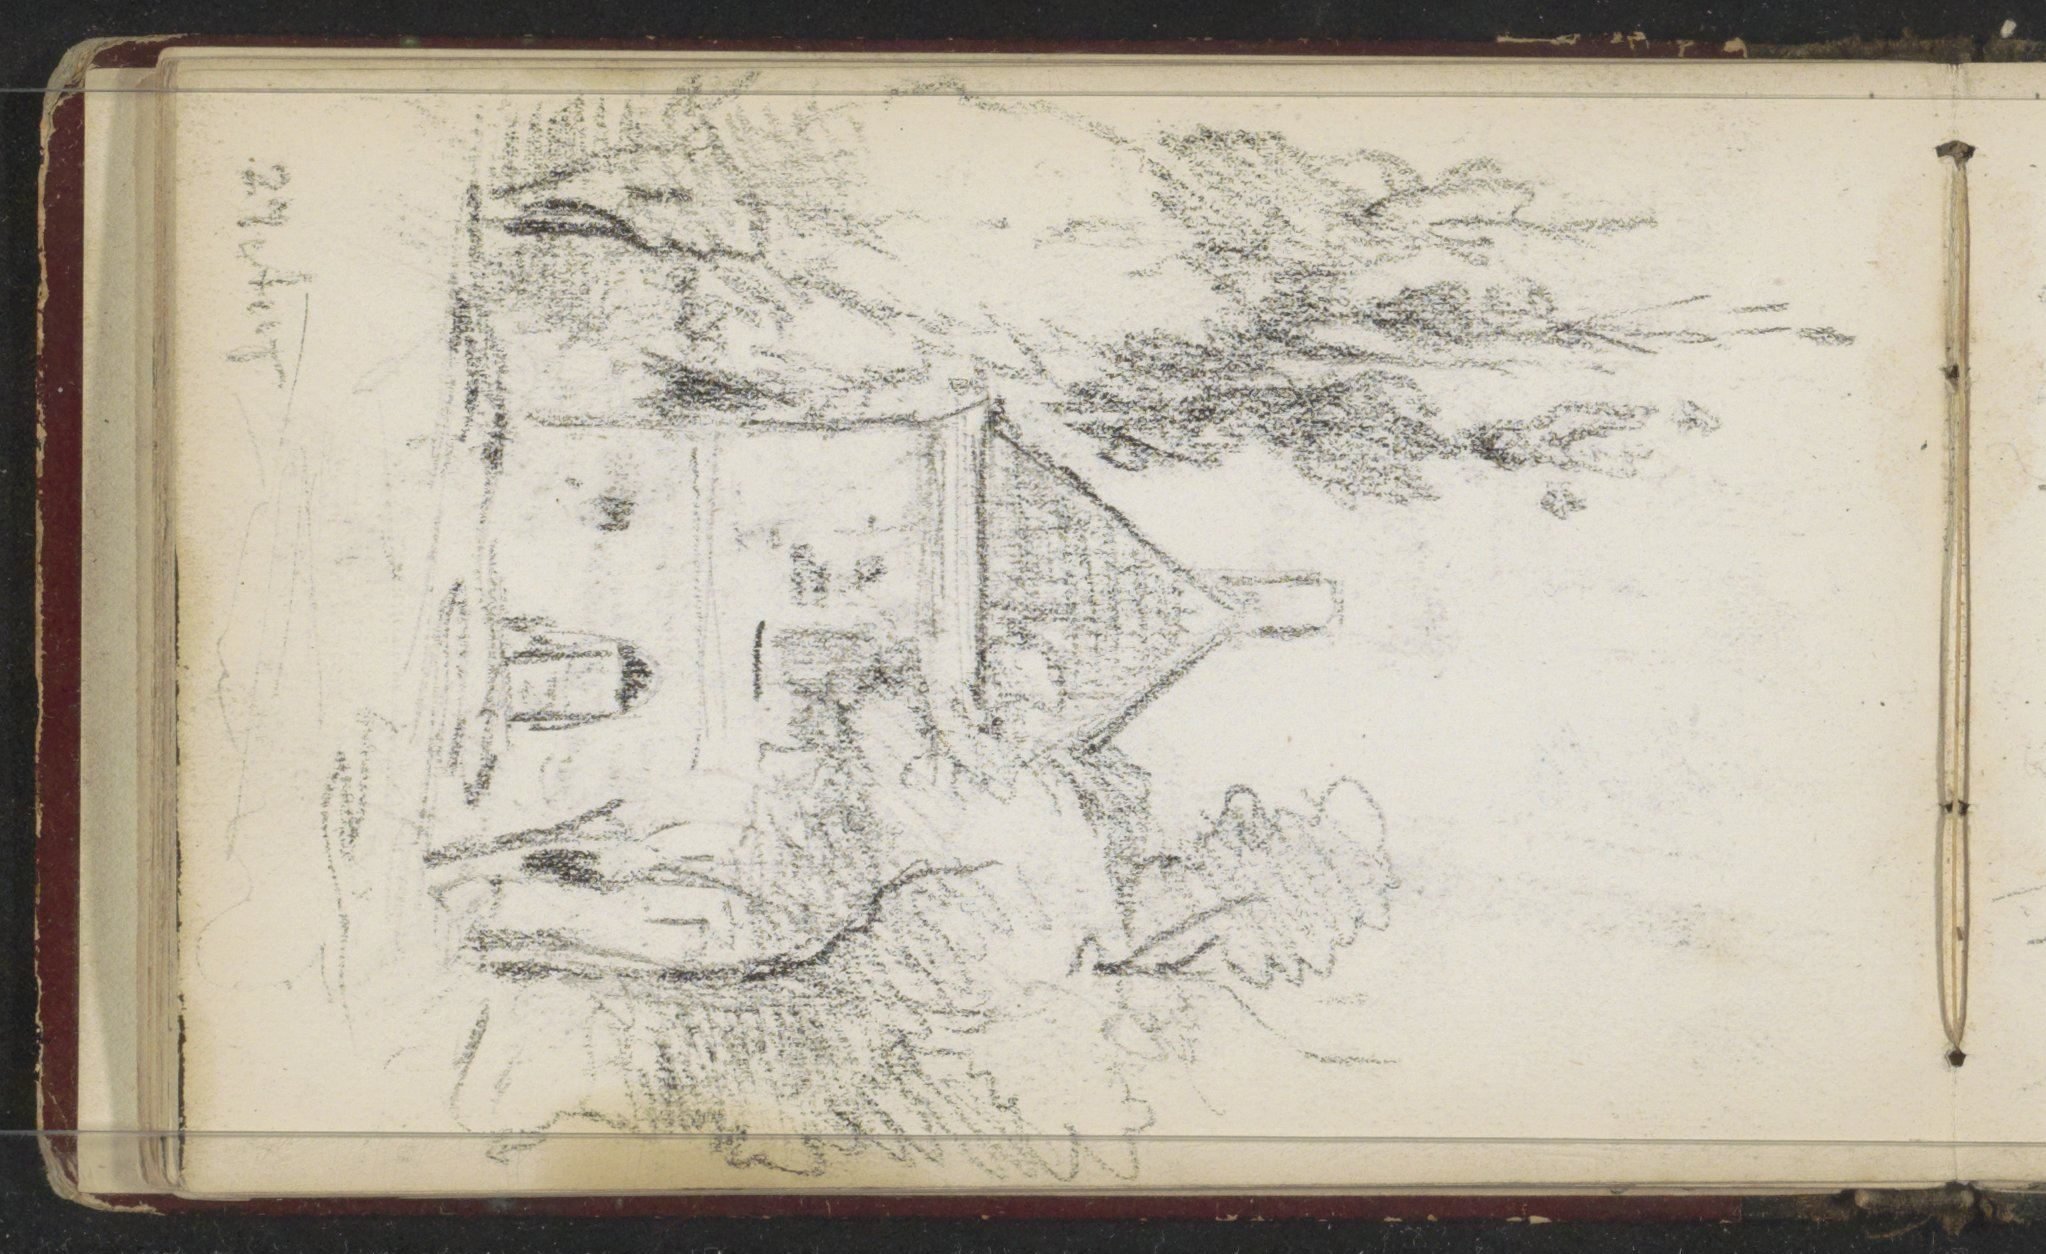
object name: sketchbook leaf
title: Huis tussen de bomen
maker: willem cornelis rip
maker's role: draughtsman, painter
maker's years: 1856-1922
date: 1808-1891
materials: chalk, paper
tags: trees, farm or solitary house in landscape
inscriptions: date: ‘27 Aug’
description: Blad 20 verso uit een schetsboek met 28 bladen.